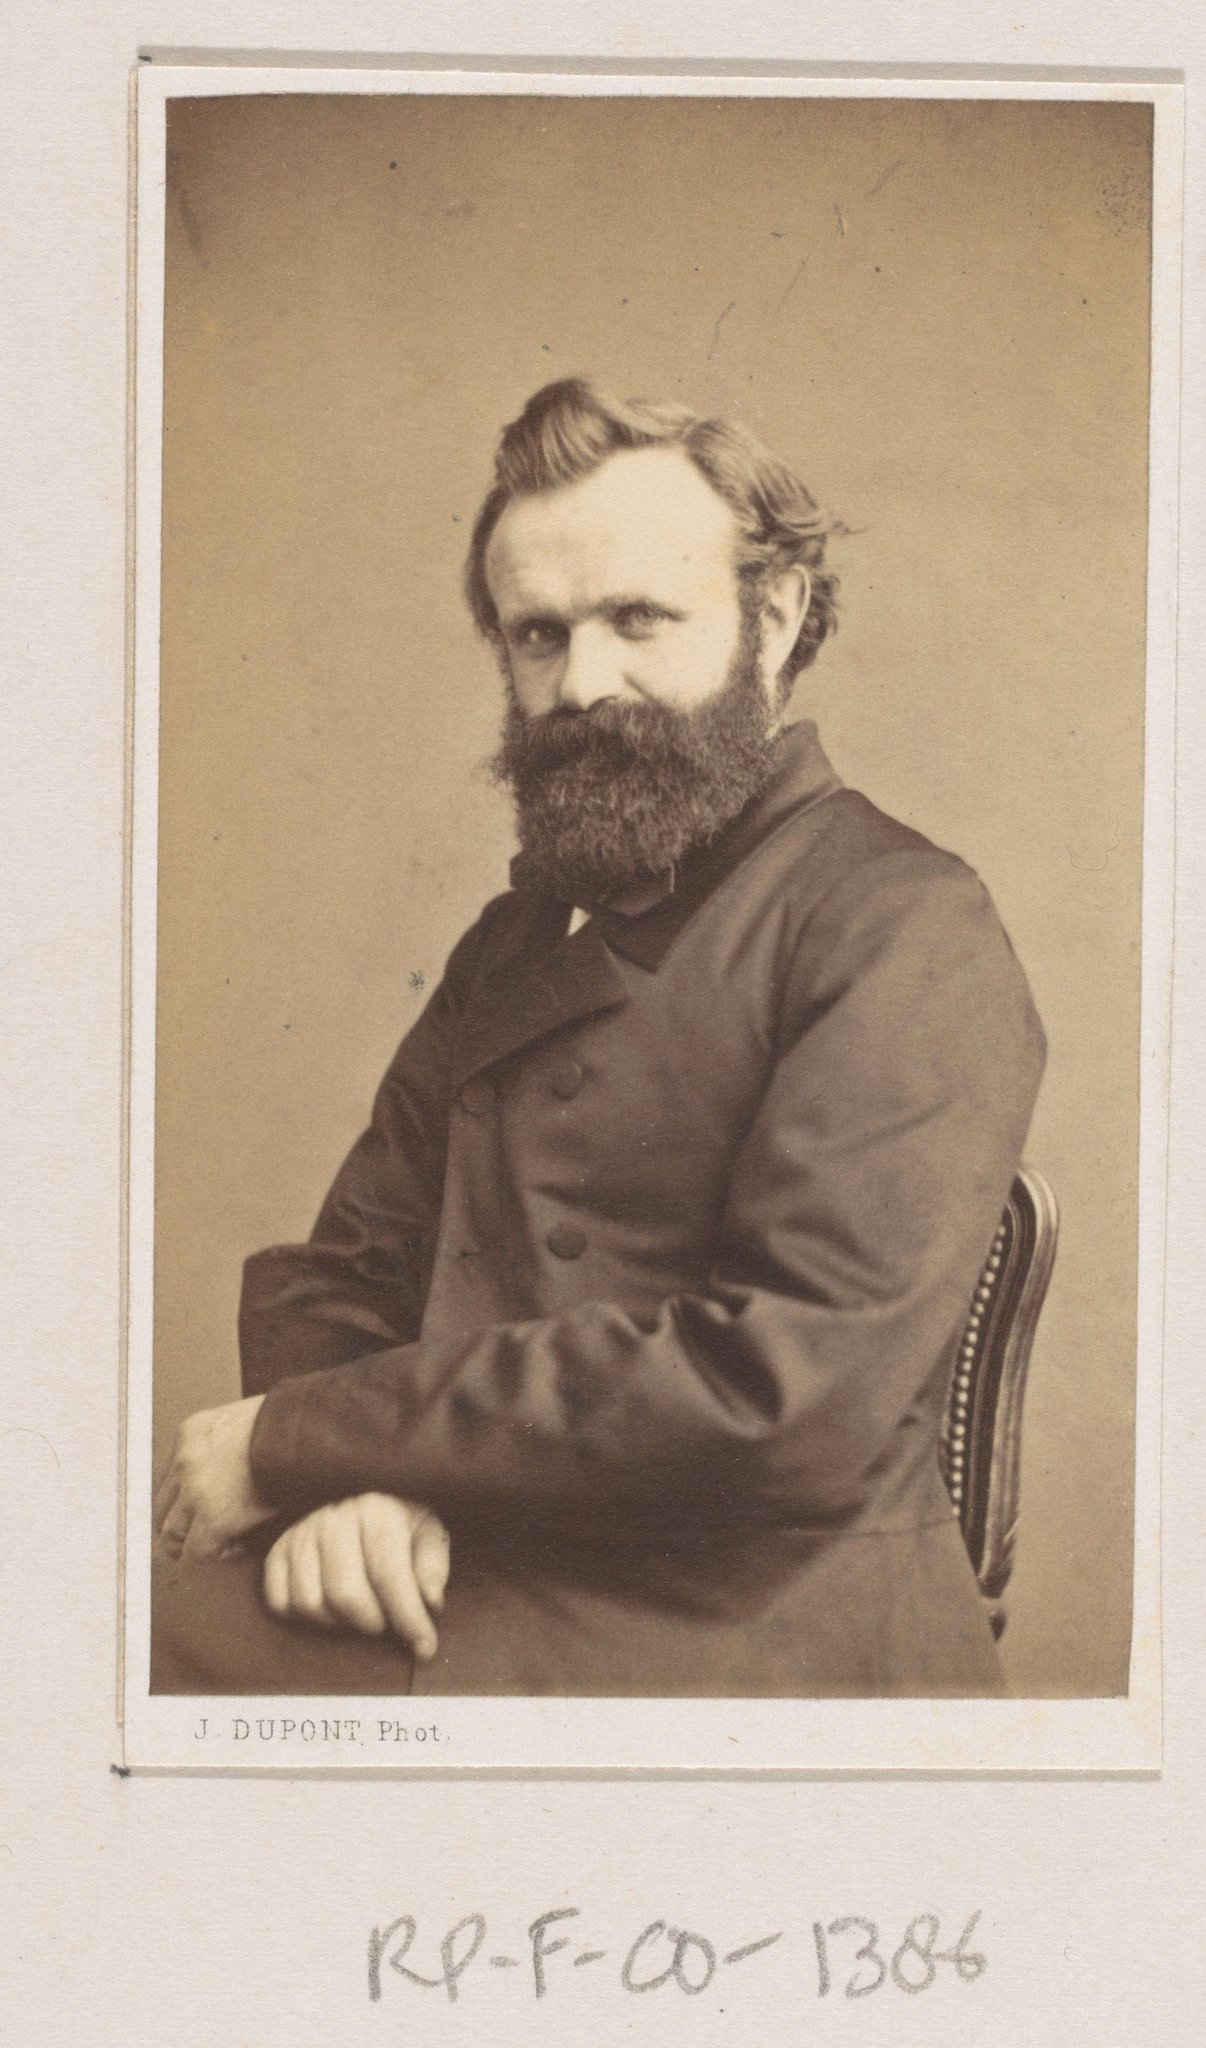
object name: carte de visite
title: L'École d'Anvers. Portraits biographies cartes de visite. Collection Dupont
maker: joseph dupont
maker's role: fotograaf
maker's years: 1818-1901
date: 1861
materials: cardboard, paper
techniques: albumen print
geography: antwerp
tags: riesenbeck, antwerp, johan bernhard wittkamp, historical persons, portrait, self-portrait of painter, portrait, self-portrait of artist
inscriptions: inscription: ‘ETABLISSEMENT PHOTOGRAPHIQUE/ de/ J. DUPONT/ Place de Meir 32/ ANVERS/ Maison fondée en 1853’